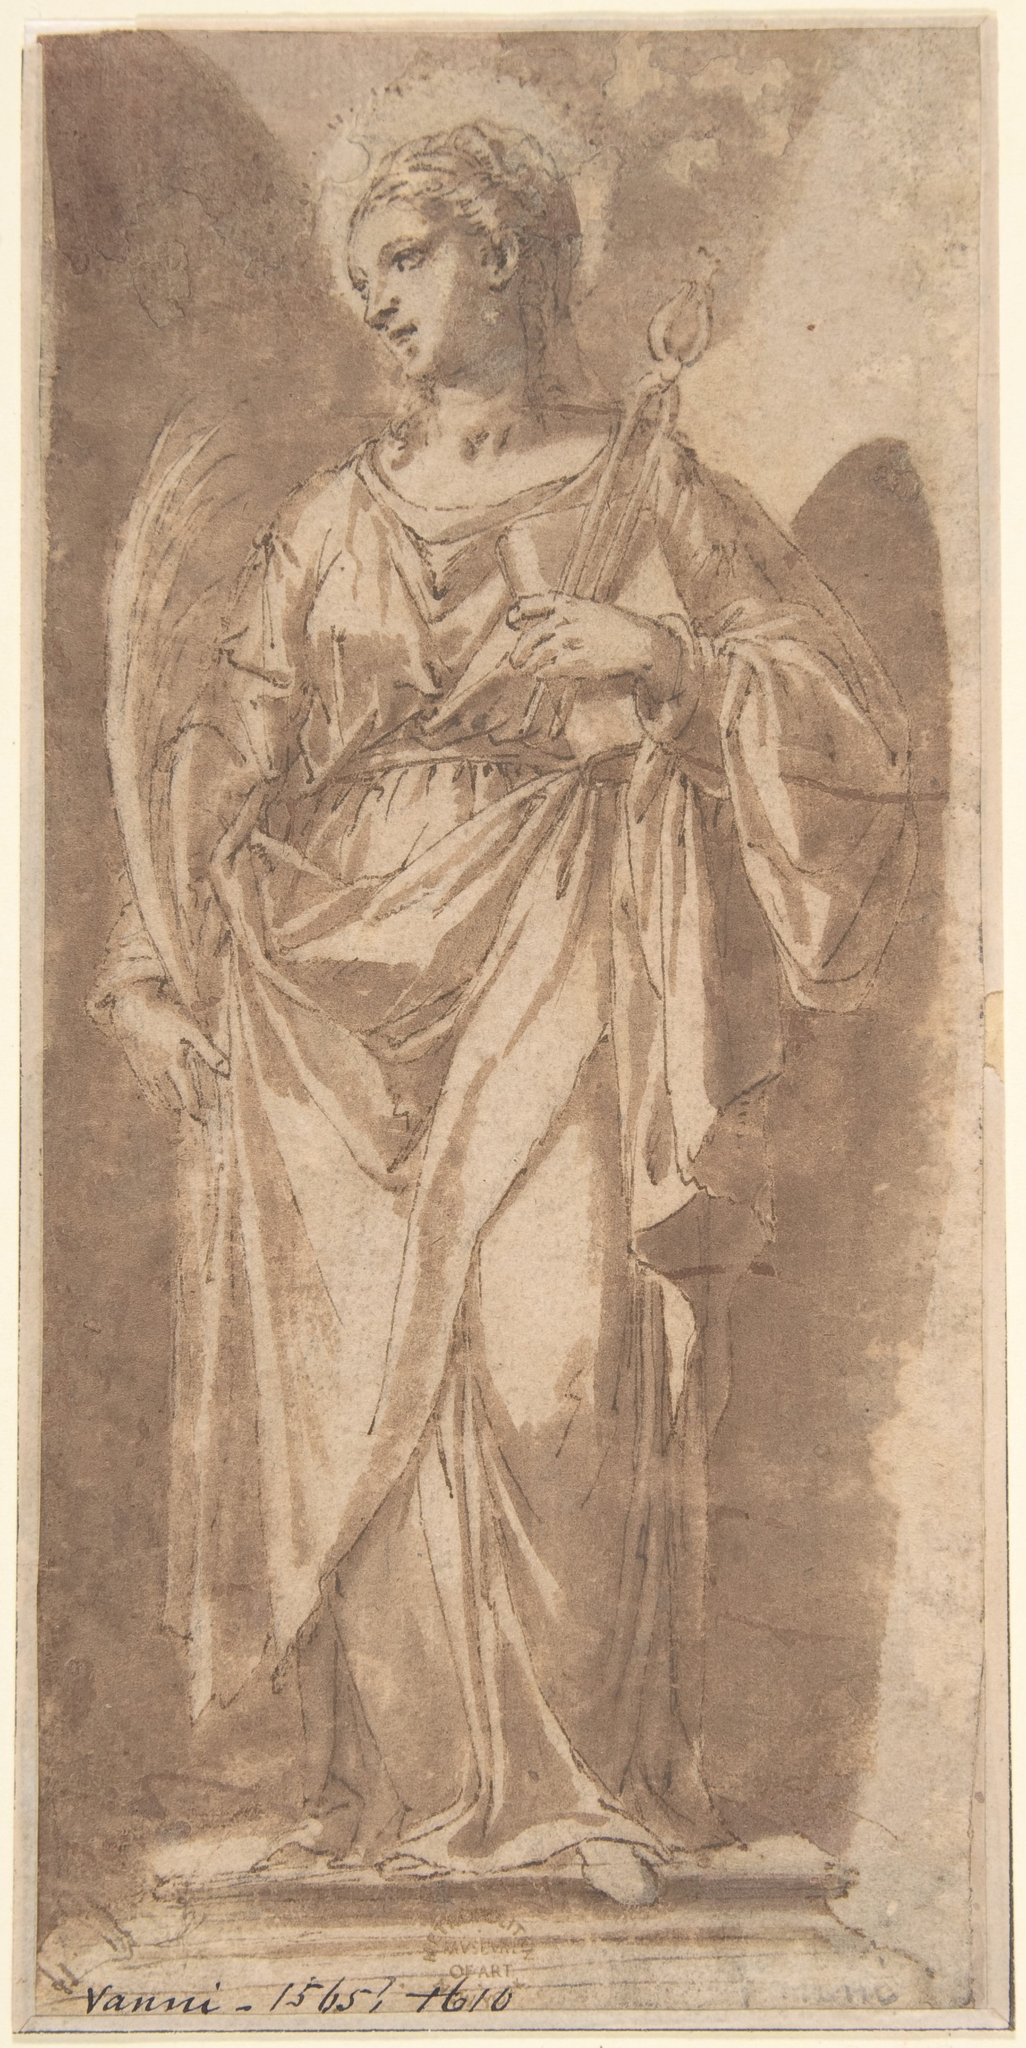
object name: drawing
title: Saint Apollonia of Alexandria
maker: anonymous, italian, roman-bolognese, 17th century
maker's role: artist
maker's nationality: italian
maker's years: 1600-1700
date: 1601-1700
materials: ink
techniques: brush, pen, wash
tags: women,saints